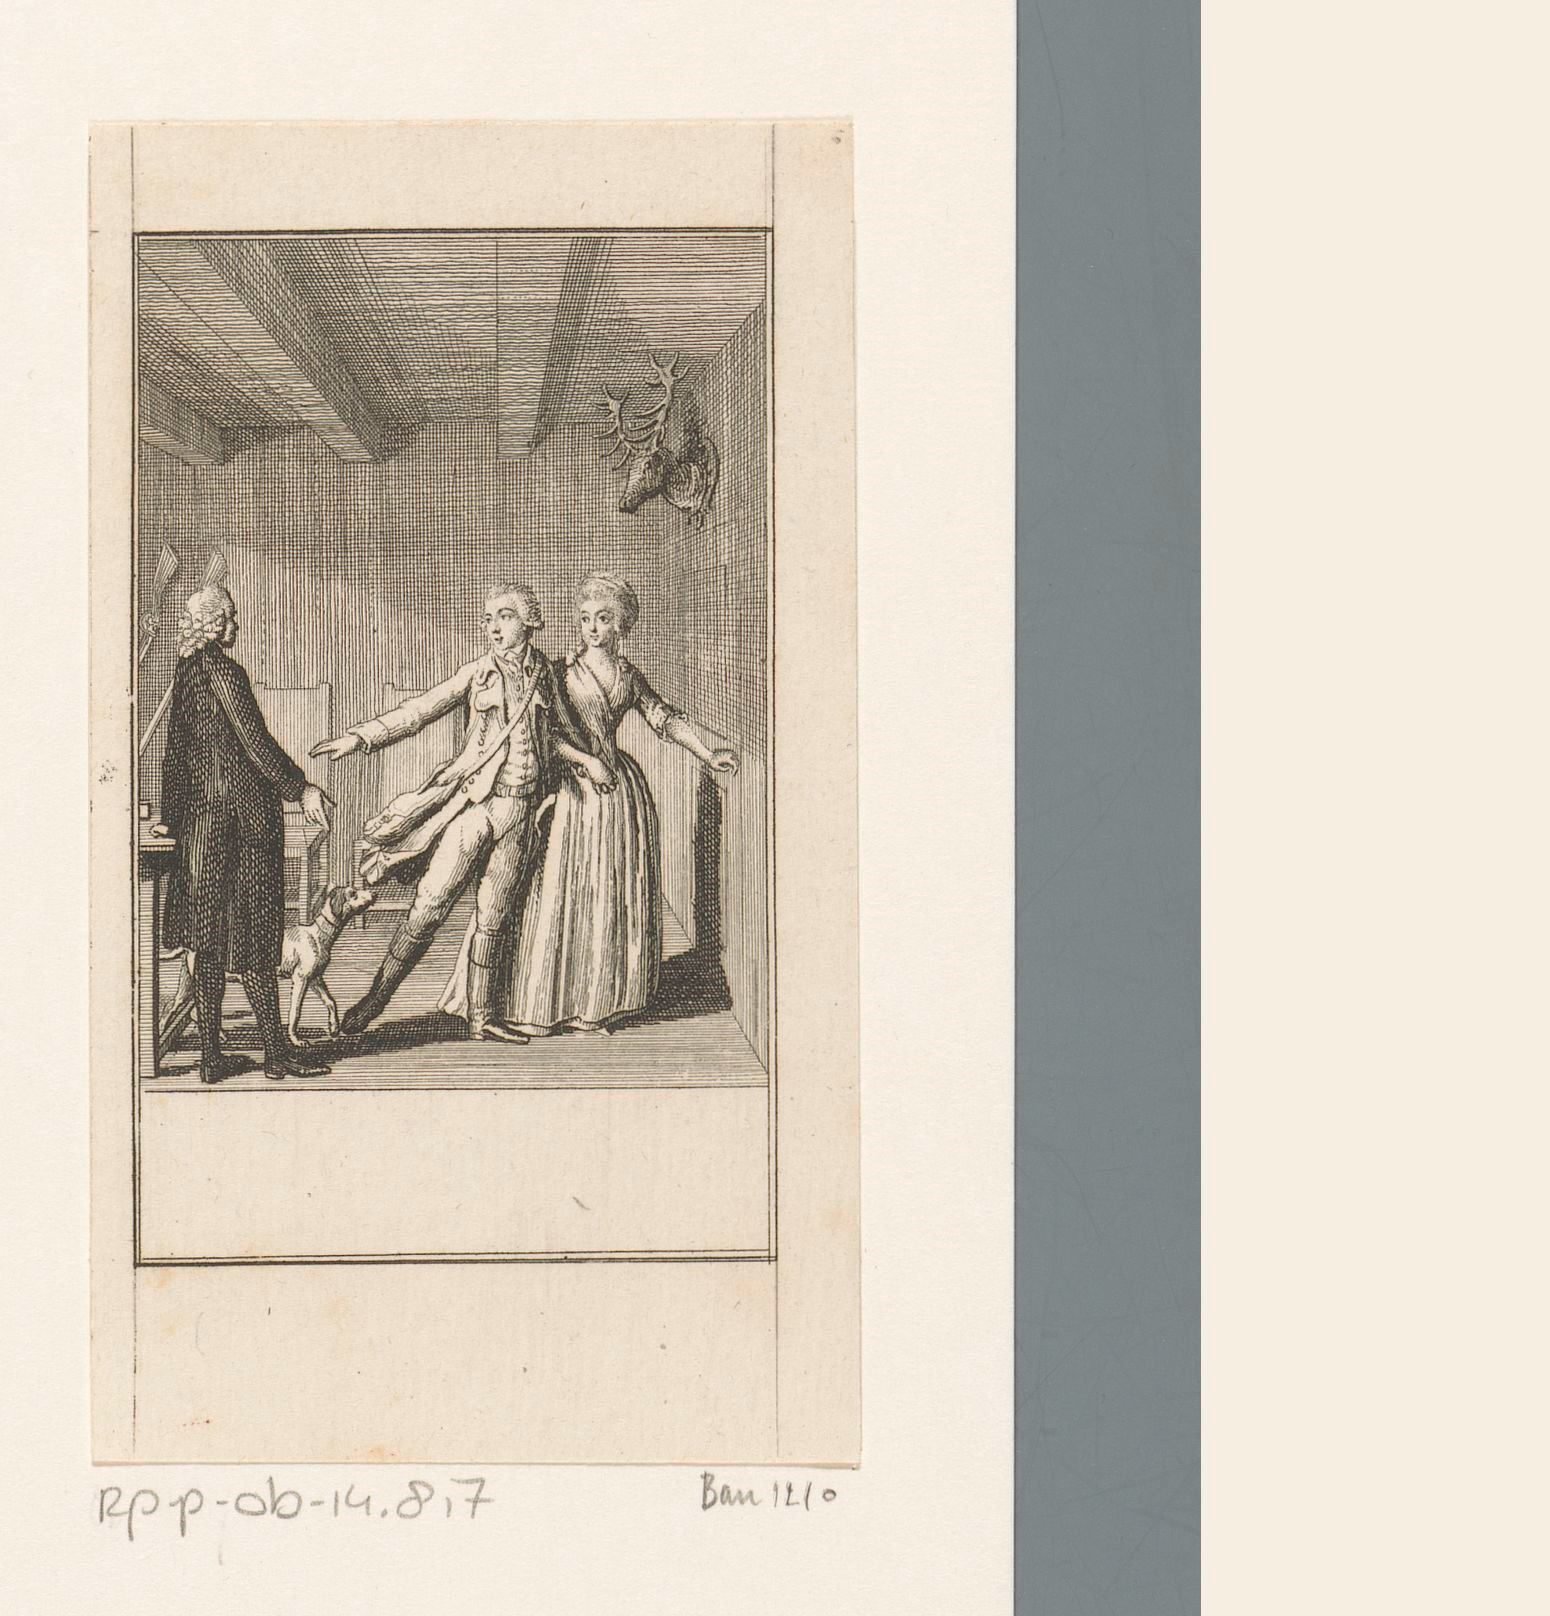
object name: print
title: Anton en Friedrike vertellen een vertrouweling over hun liefde voor elkaar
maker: daniel nikolaus chodowiecki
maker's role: draughtsman, print maker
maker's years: 1726-1801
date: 1786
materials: paper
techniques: etching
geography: berlin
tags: literature, hidden love discovered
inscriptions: collector's mark: Lugt 2228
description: Vervaardigd voor August Wilhelm Ifflands 'Die Jäger'. Latere staat gebruikt voor: Berliner genealogischen Calender auf das Jahr 1787. Berlijn: s.n., 1786.